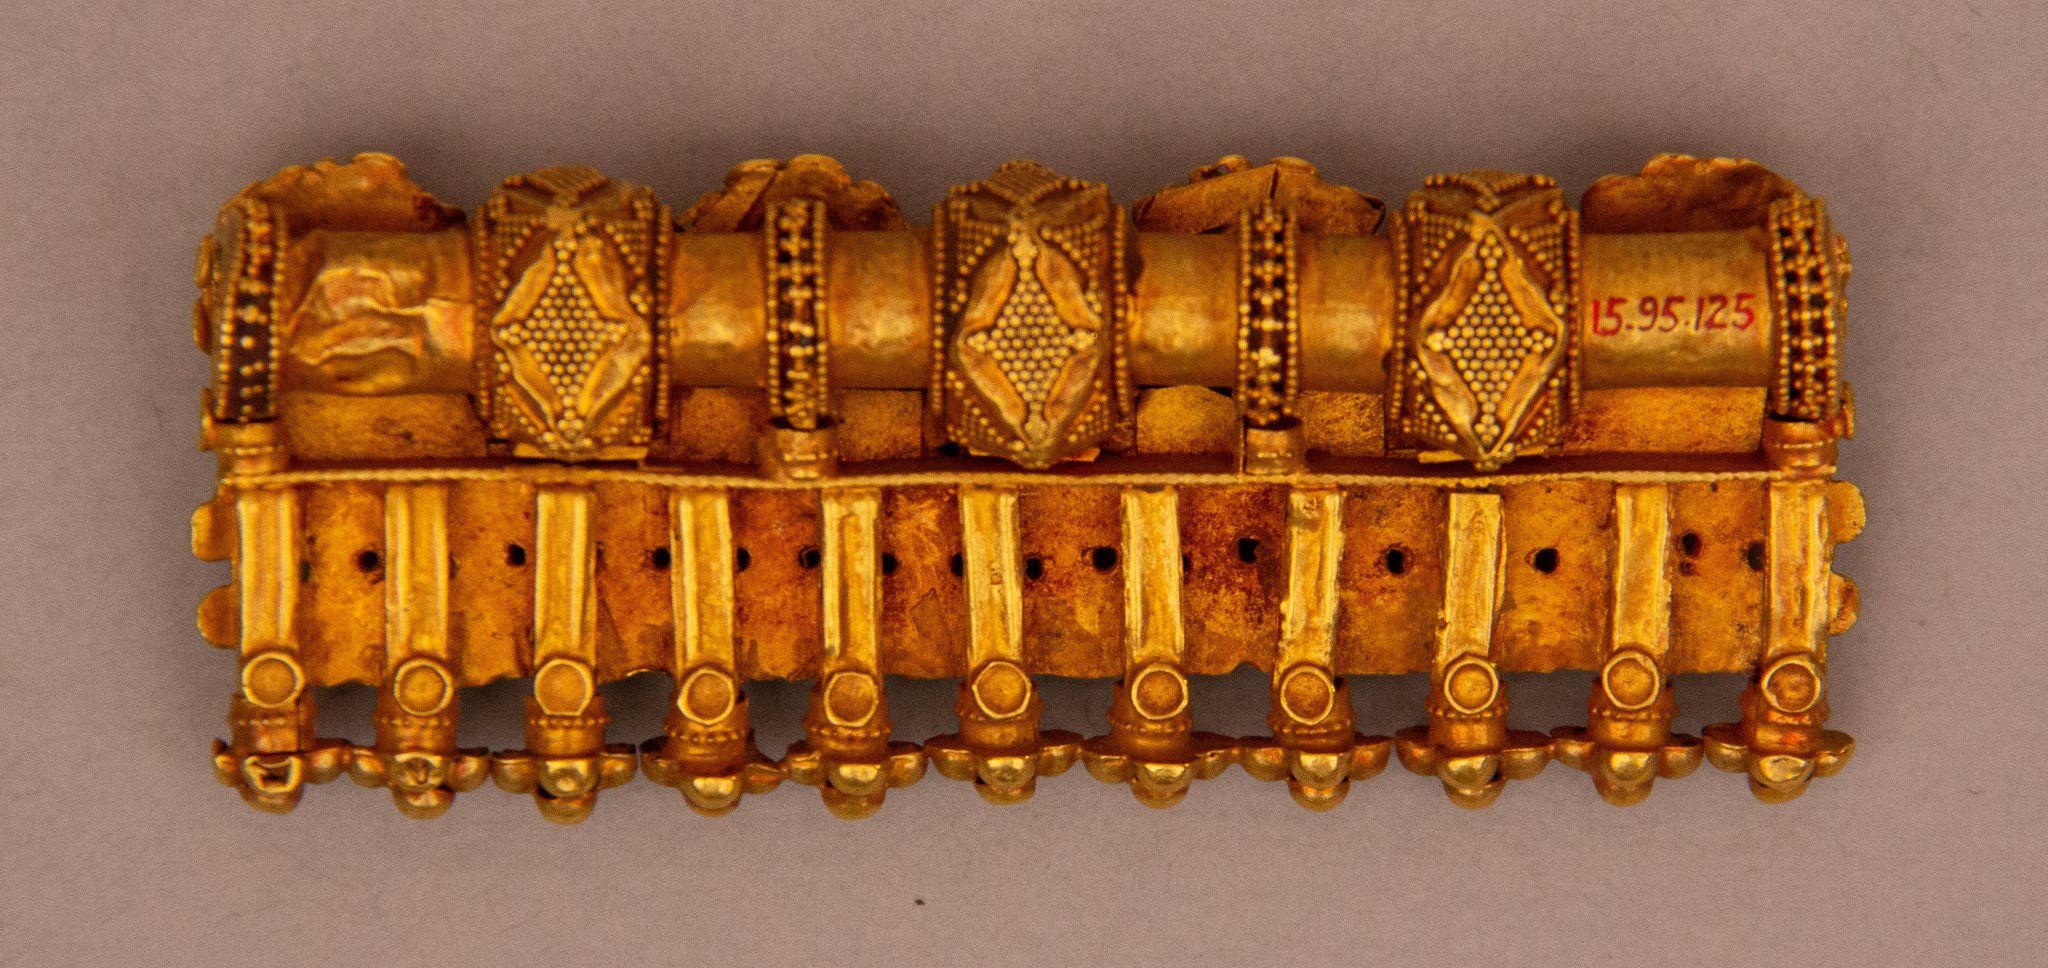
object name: pendant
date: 1801-1900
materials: gold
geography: india